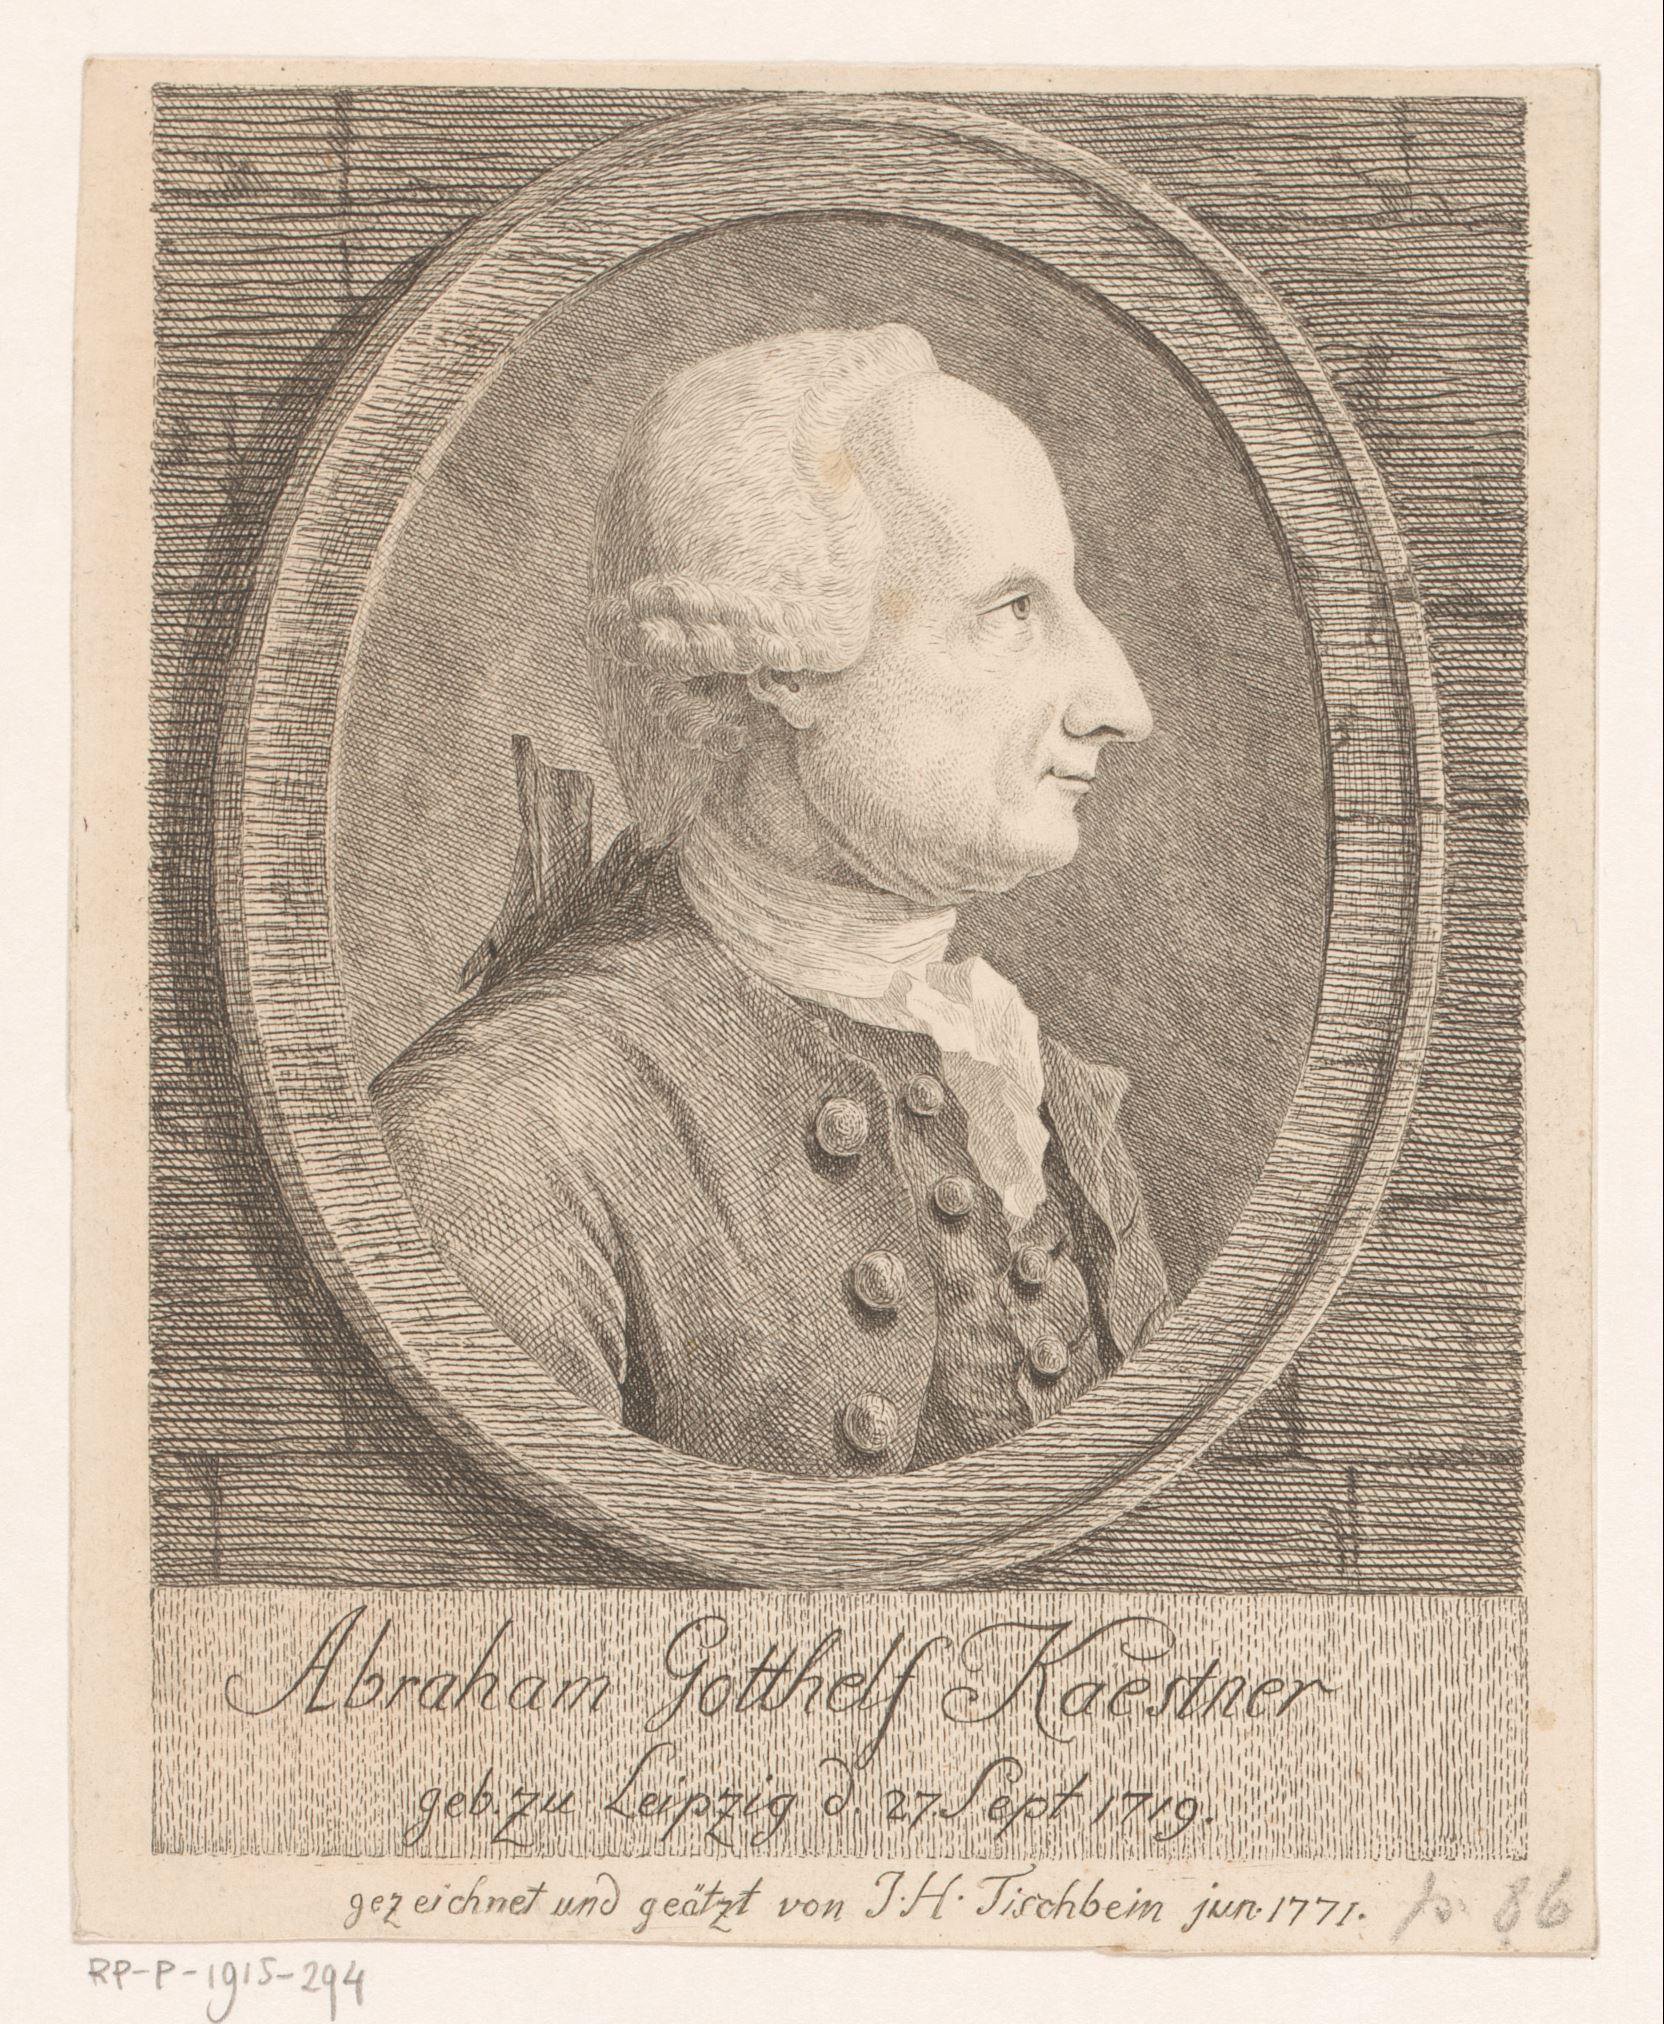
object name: print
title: Portret van Abraham Gotthelf Kaestner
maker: johann heinrich tischbein (1742-1808)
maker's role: print maker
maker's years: 1742-1808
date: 1706-1771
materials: paper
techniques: etching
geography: germany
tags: historical persons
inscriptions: collector's mark: Lugt 2228, collector's mark: Lugt 760